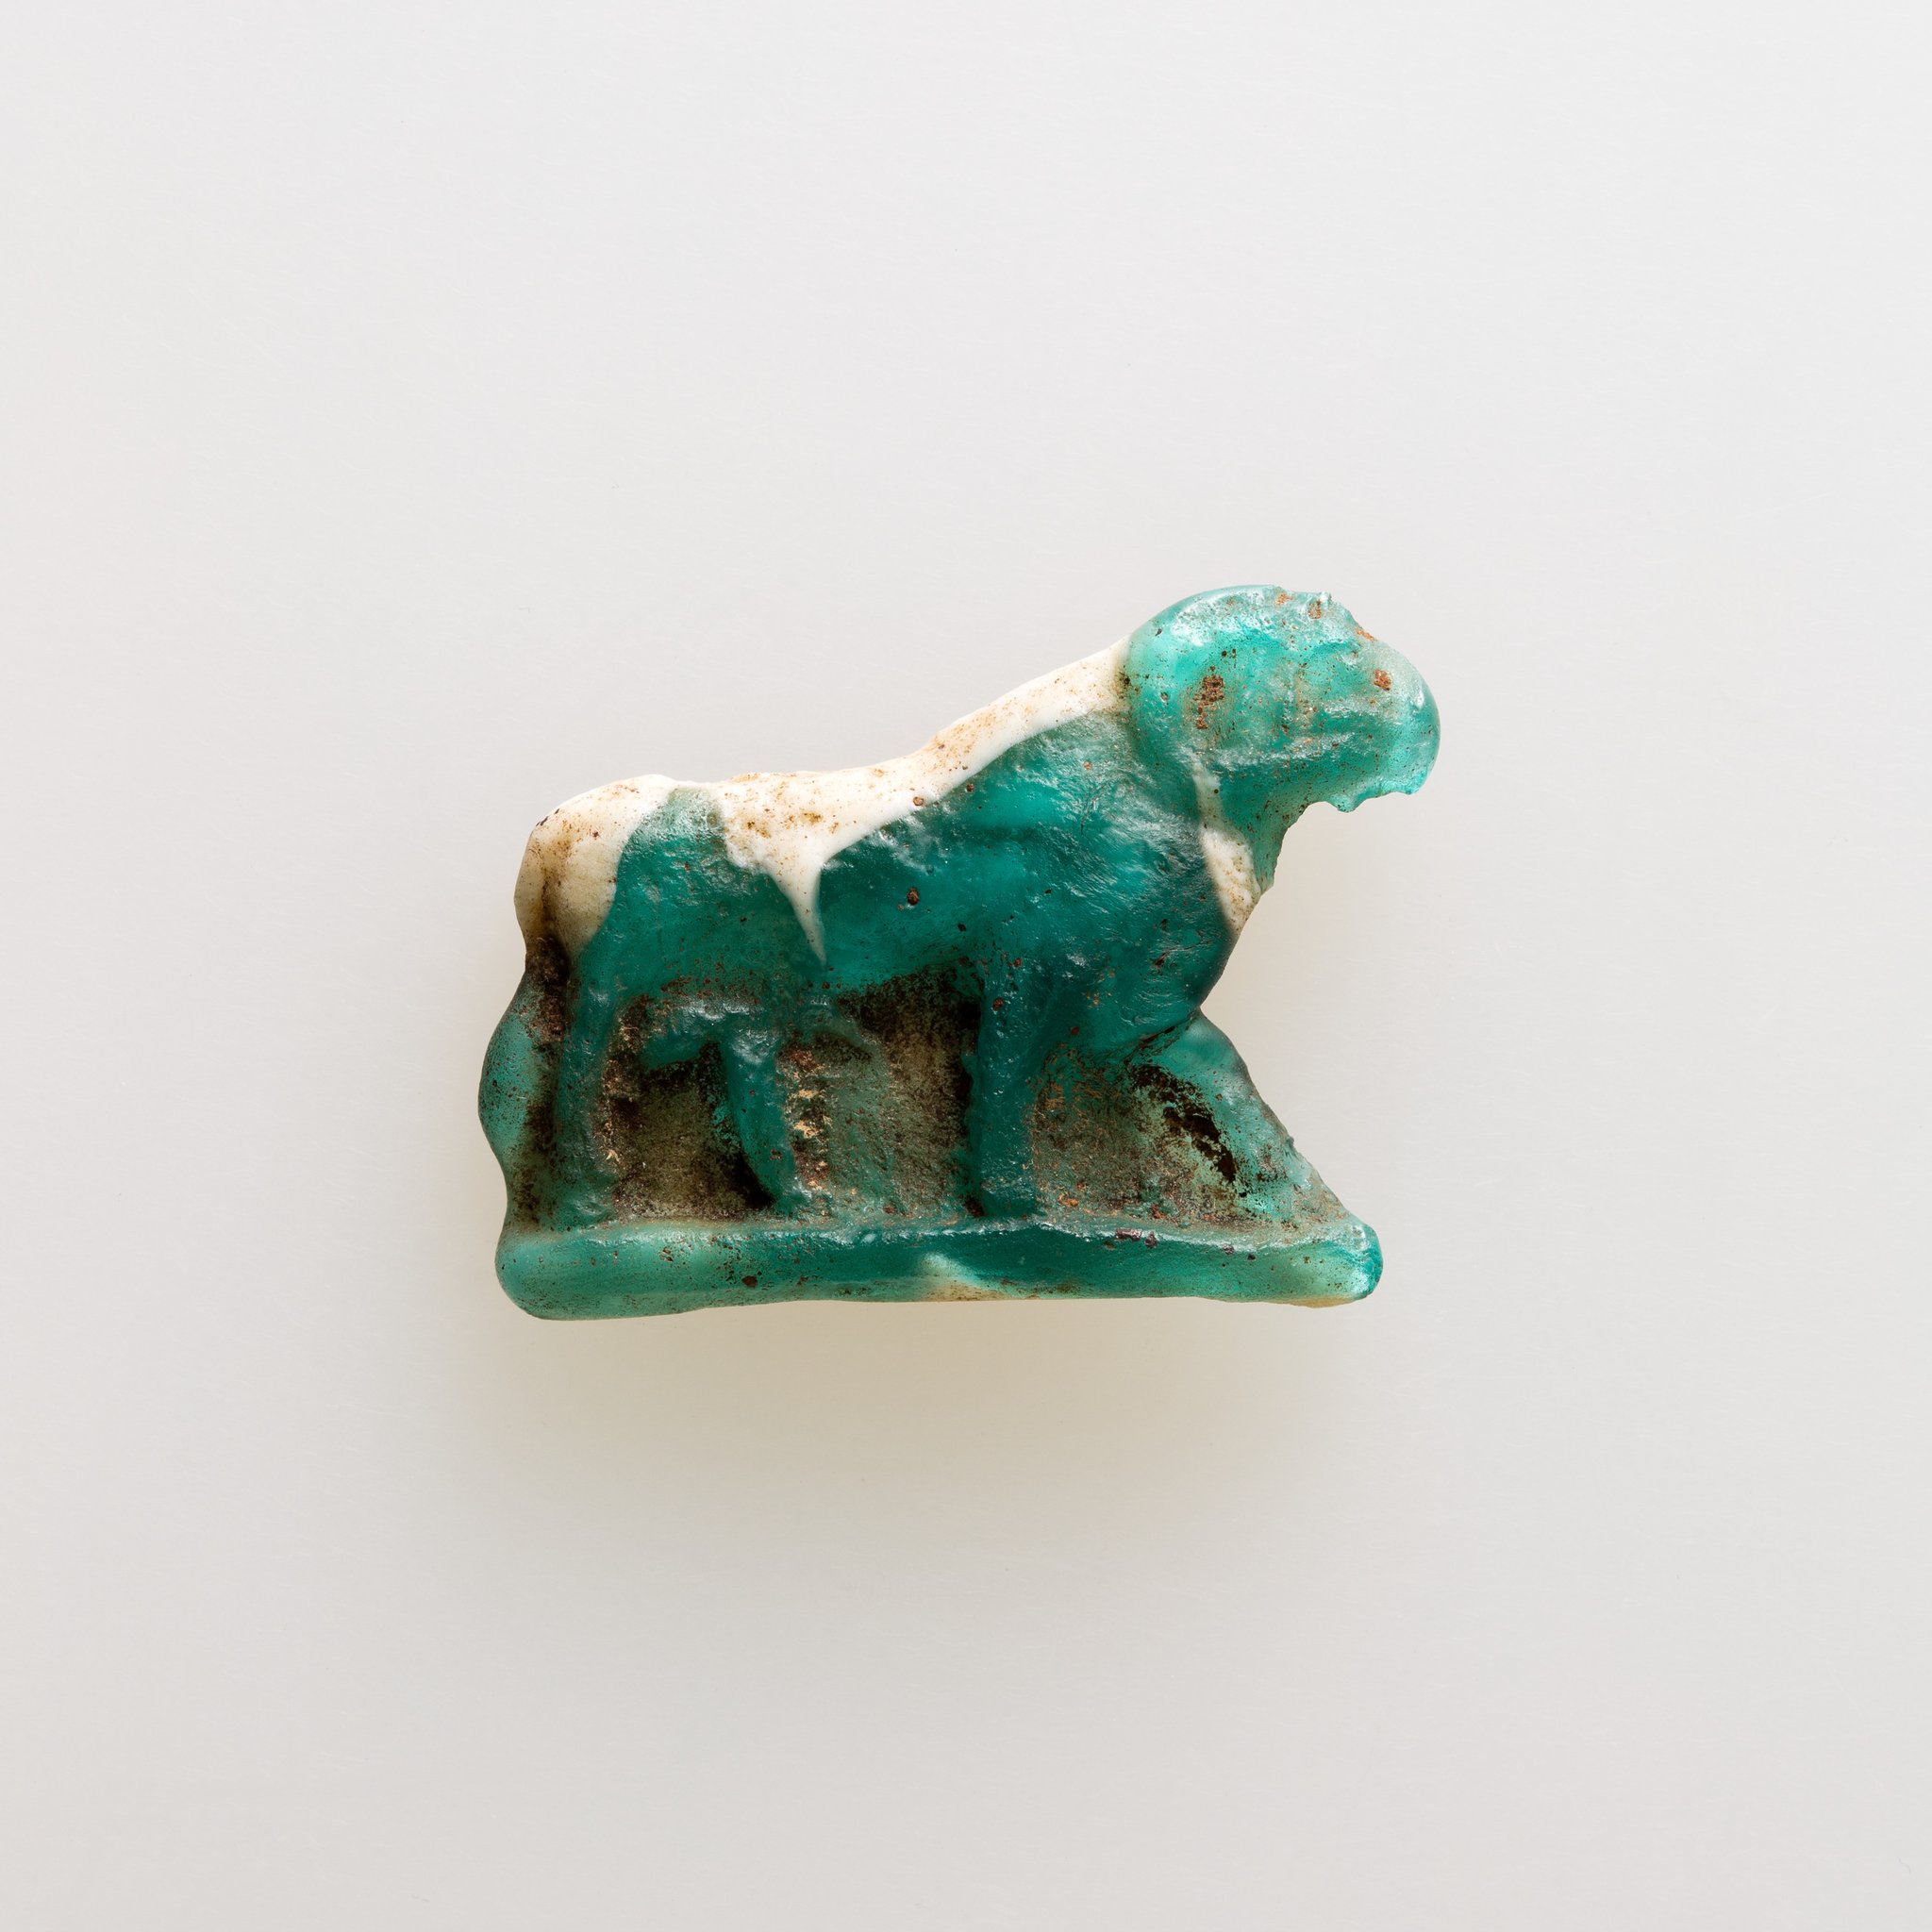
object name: amulet, ram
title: Amulet of a walking ram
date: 525-30 BCE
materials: glass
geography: egypt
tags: rams